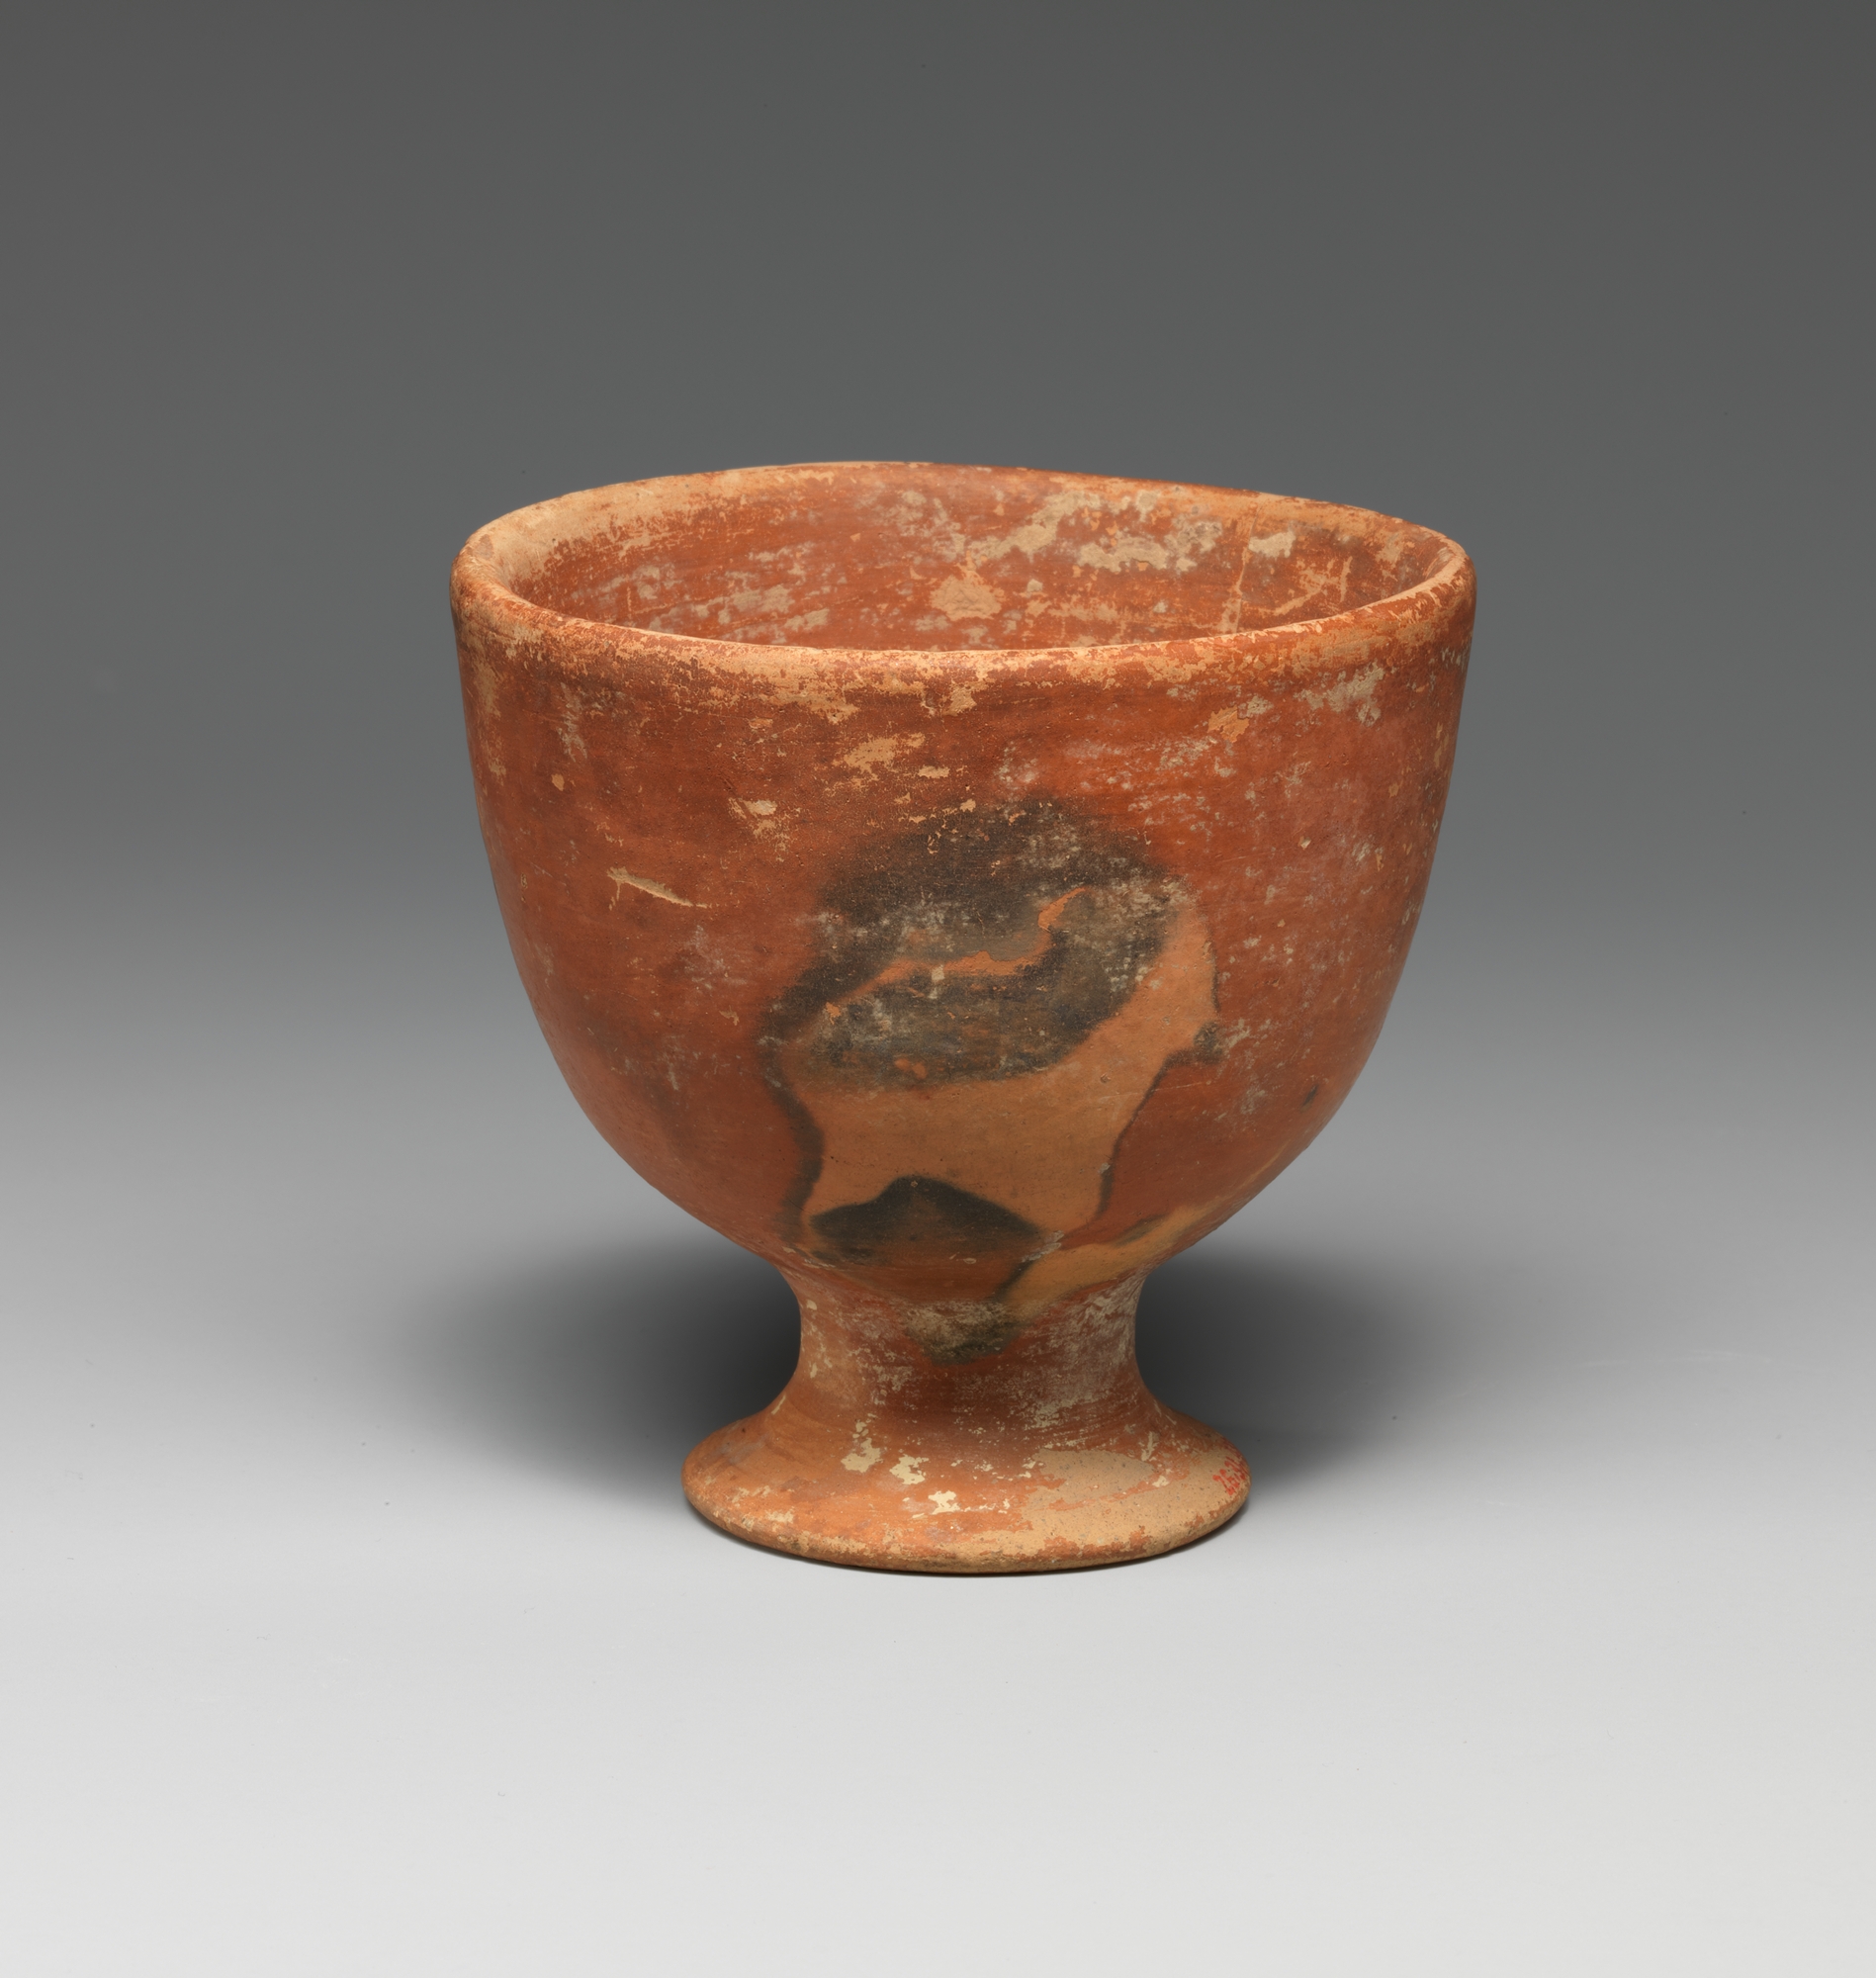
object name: cup, stemmed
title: Terracotta footed cup, Vasiliki ware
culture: minoan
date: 2600-2200 BCE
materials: terracotta